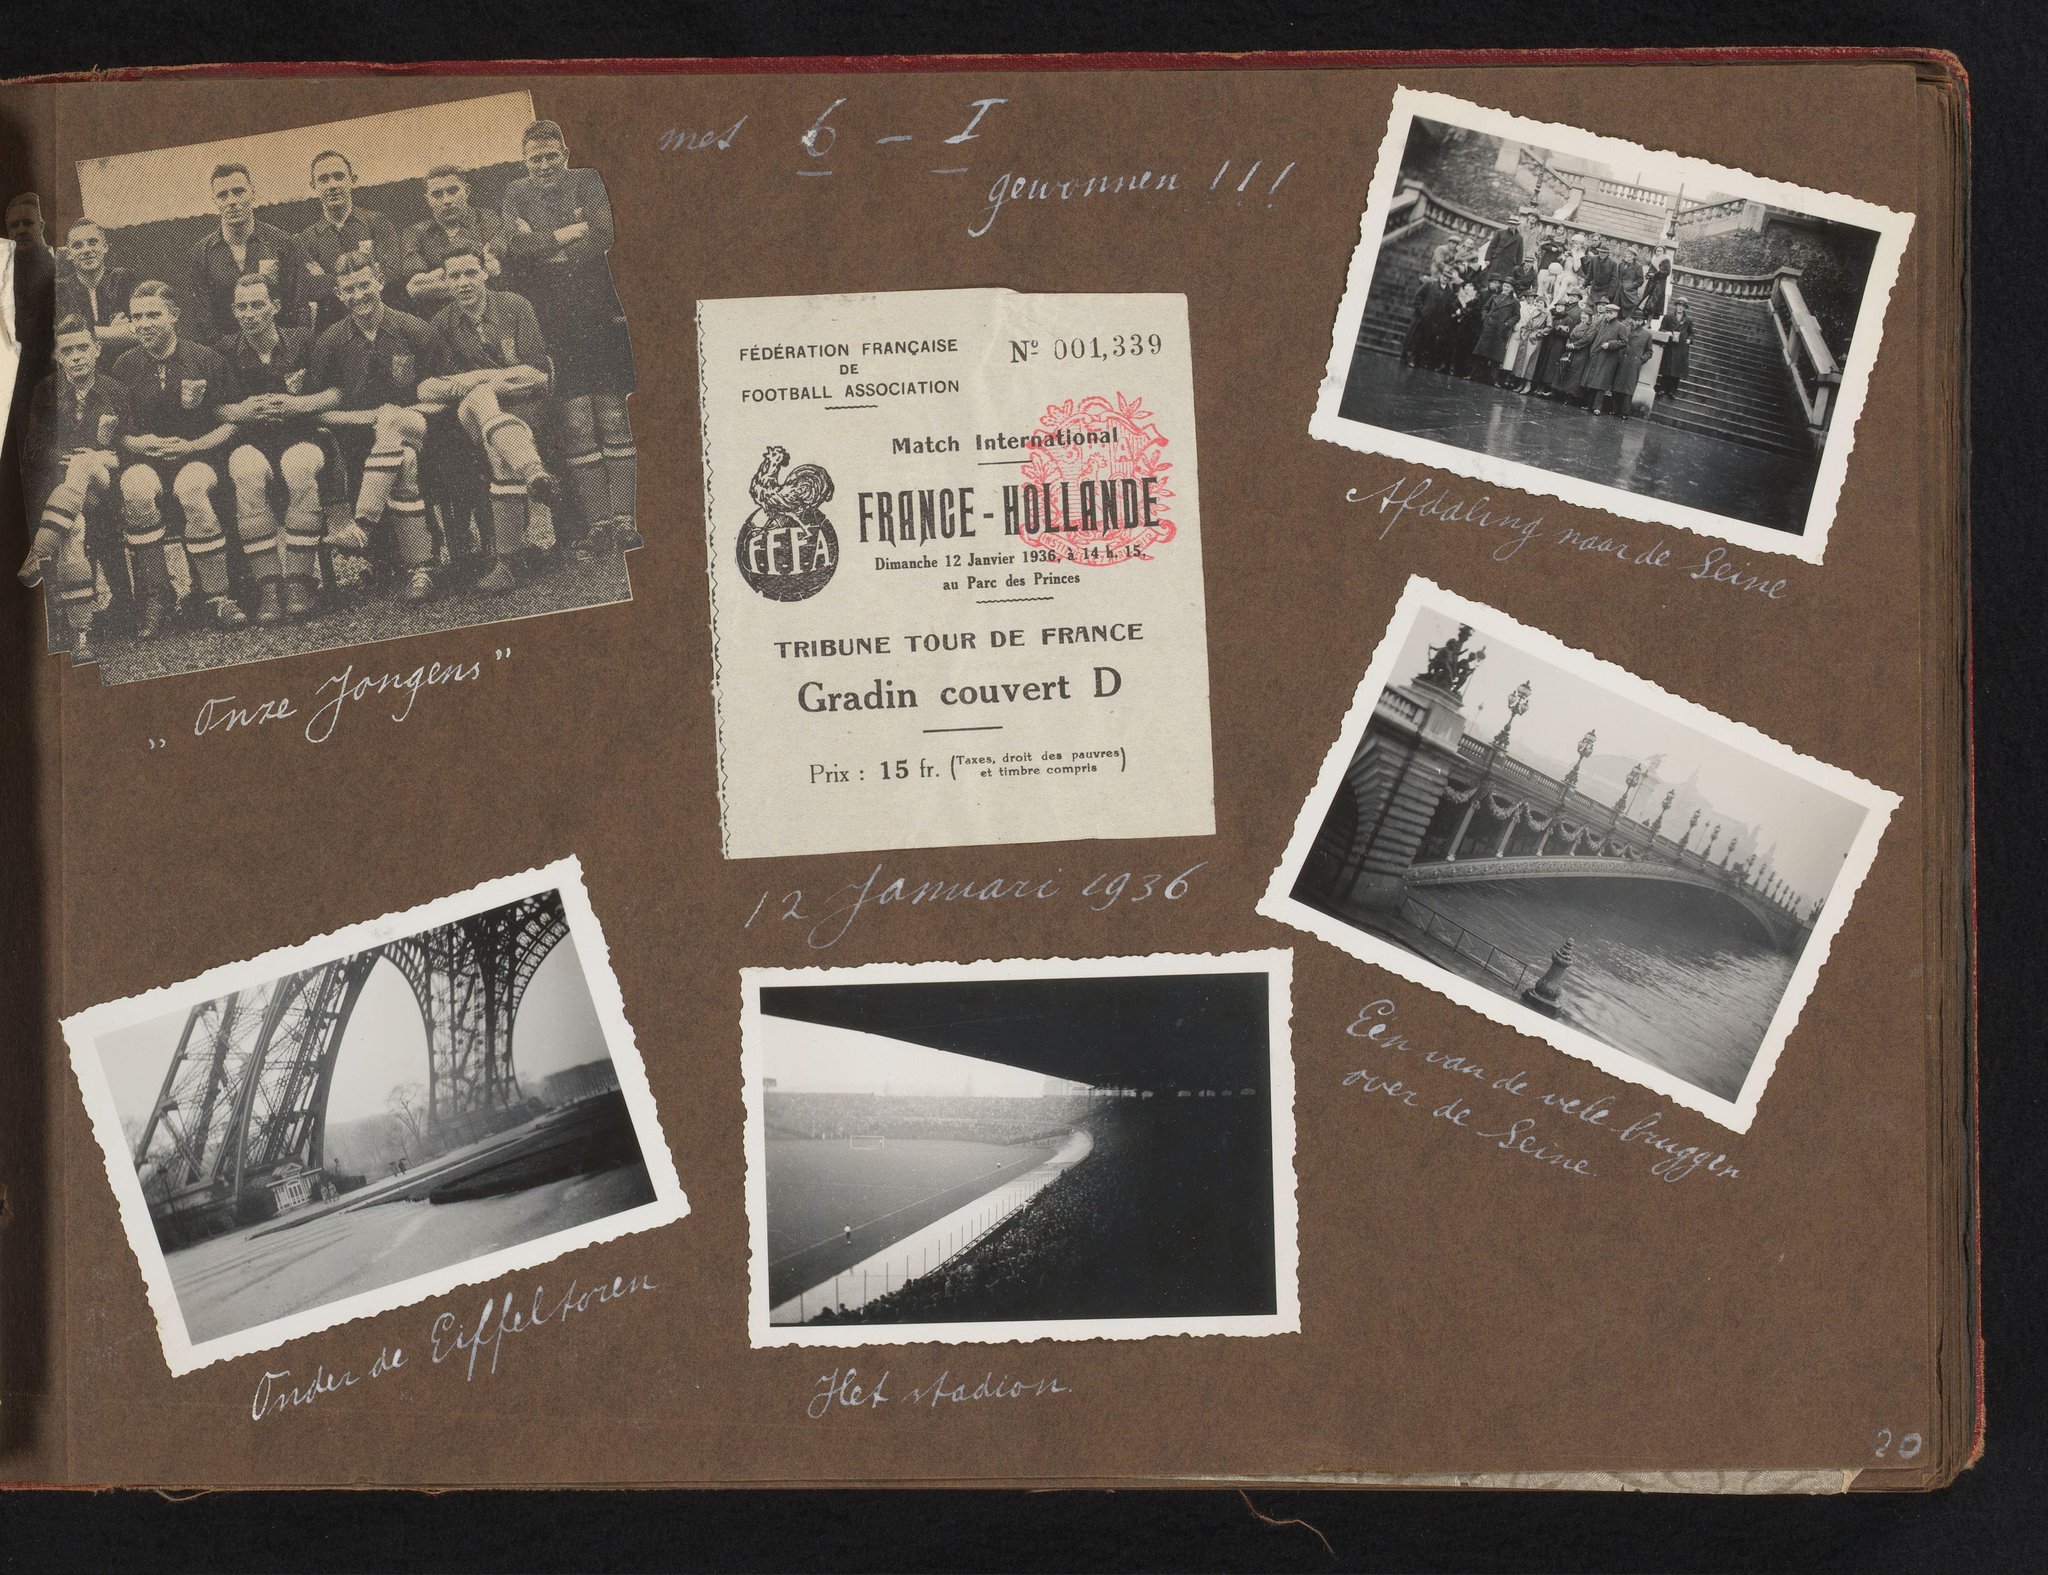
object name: newspaper clipping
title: Bezoek aan Parijs voor de voetbalwedstrijd Frankrijk-Nederland, 1936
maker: Anonymous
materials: paper, photographic support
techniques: gelatin silver print, offset printed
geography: paris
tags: soccer, football (early names: soule, choule, cholle), outing, pleasure trip, parc des princes, paris, eiffel tower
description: Albumblad met vier foto's, een toegangskaartje voor een voetbalwedstrijd en een krantenknipsel. Op 11 januari 1936 vertrekt de samensteller van het fotoalbum naar Parijs om daar op 12 januari een voetbalwedstrijd tussen Frankrijk en Nederland bij te wonen (Nederland wint met 6-1). Foto's van Parijs (Seine, Eiffeltoren) in de regen en van het voetbalstadion Parc des Princes. Onderdeel van het reisalbum van de familie Van den Broek 1935-1937.